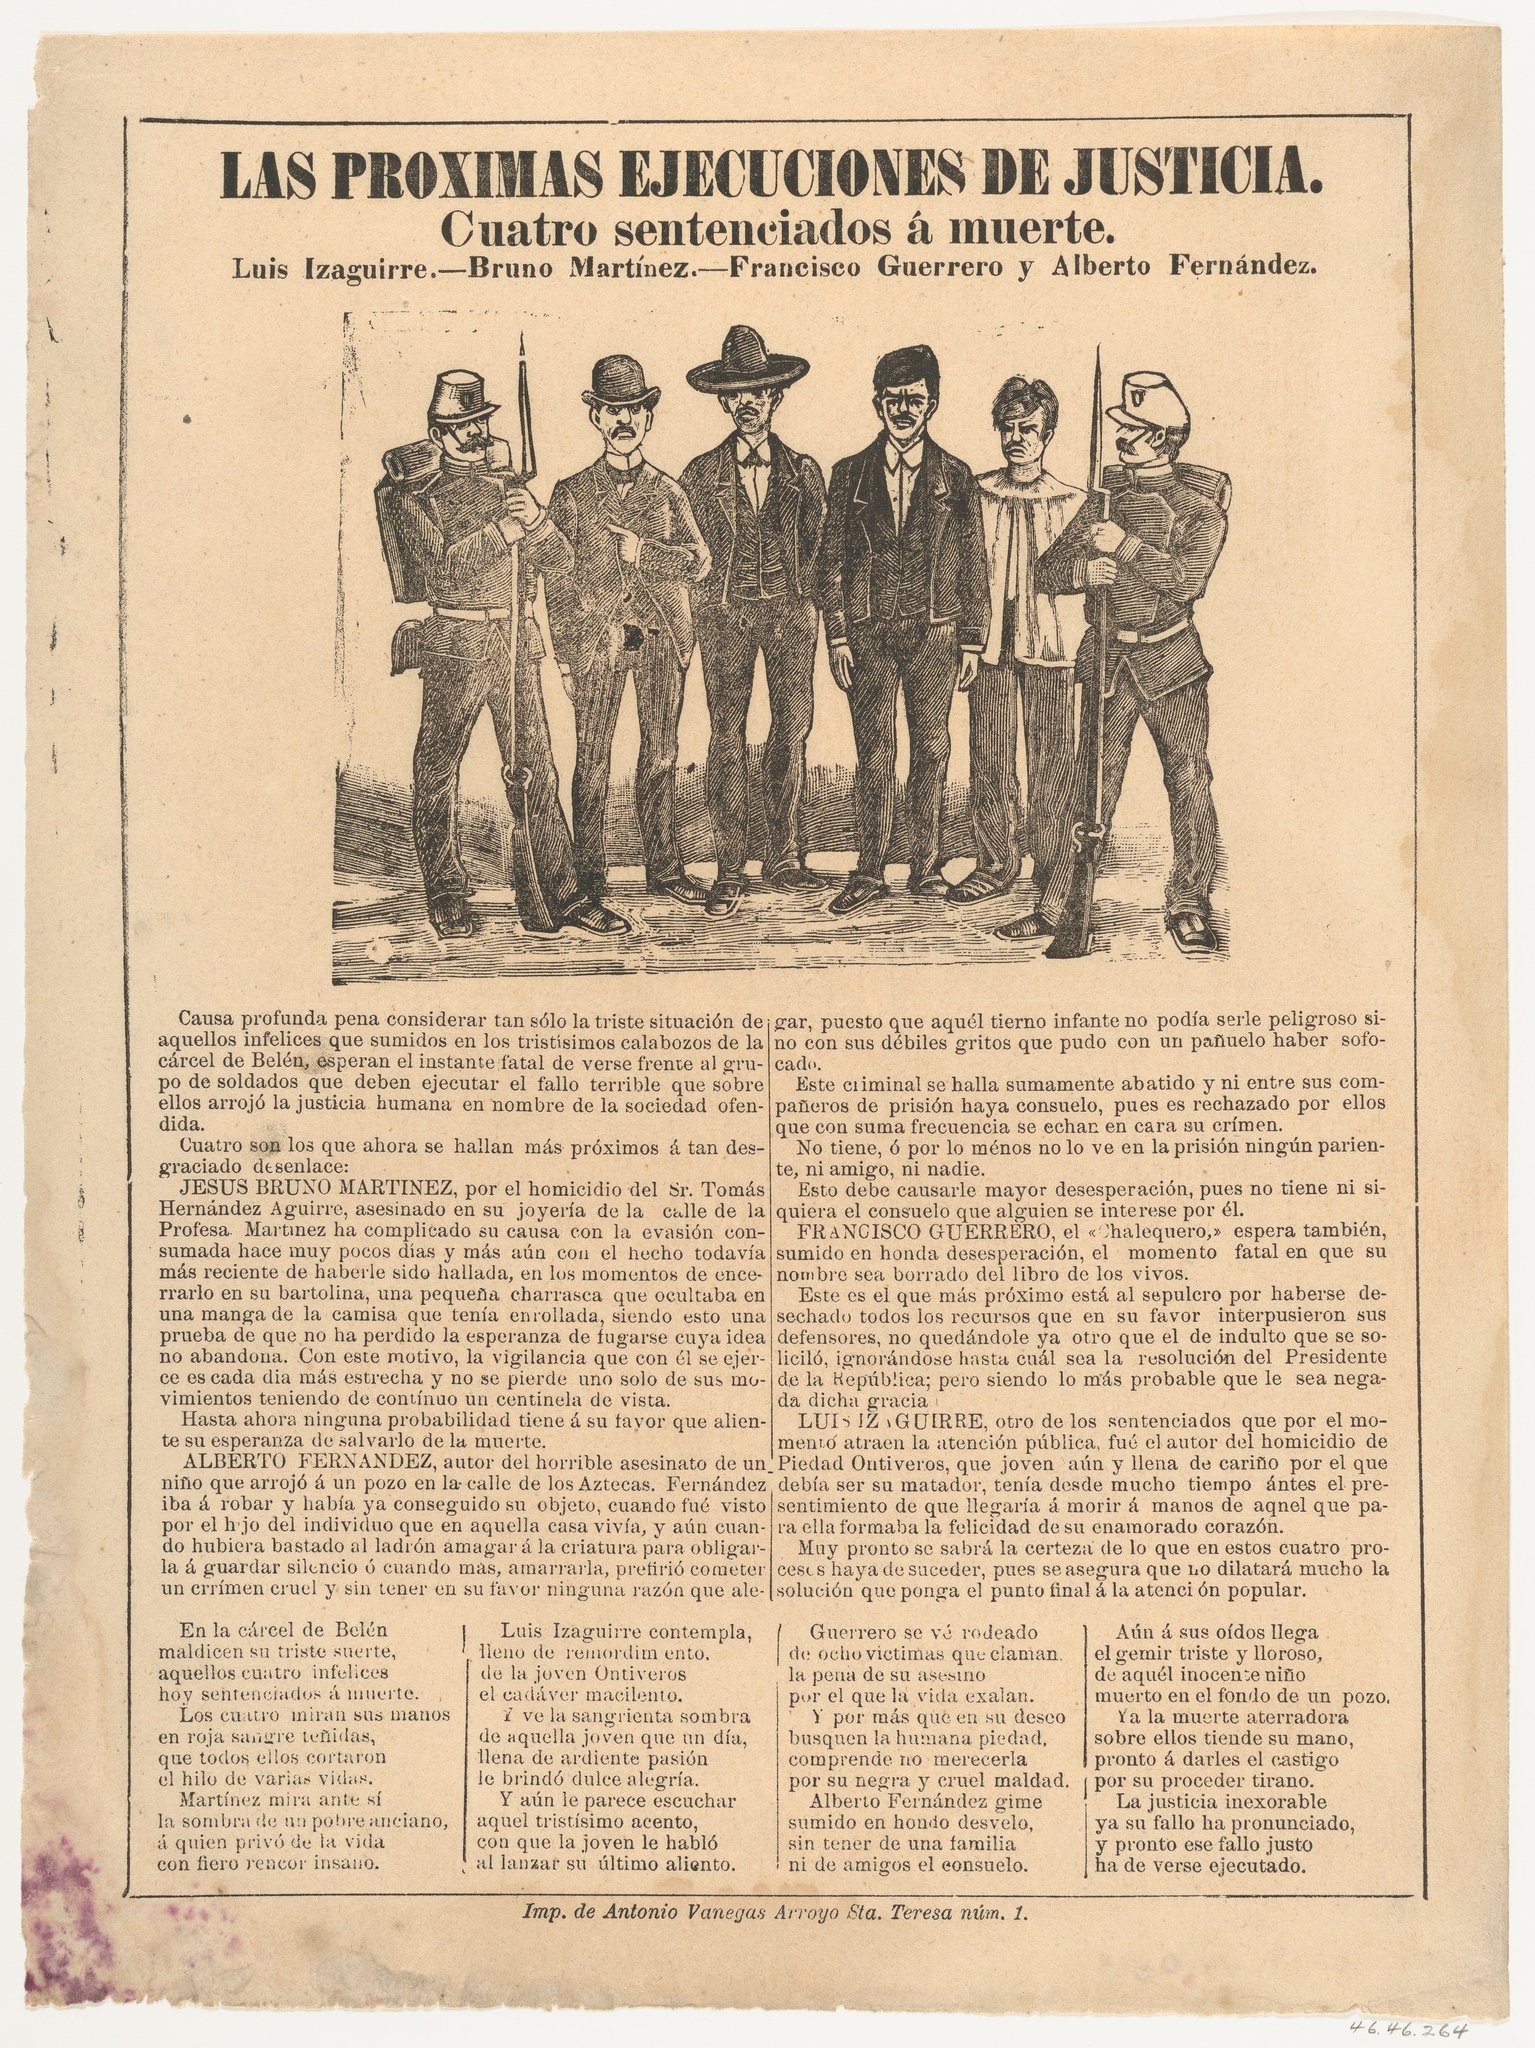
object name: print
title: Broadsheet relating to the execution of four men in the name of justice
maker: josé guadalupe posada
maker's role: artist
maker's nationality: mexican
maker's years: 1852-1913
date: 1890-1910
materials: metal, paper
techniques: engraving, letterpress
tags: soldiers,men,execution,documents